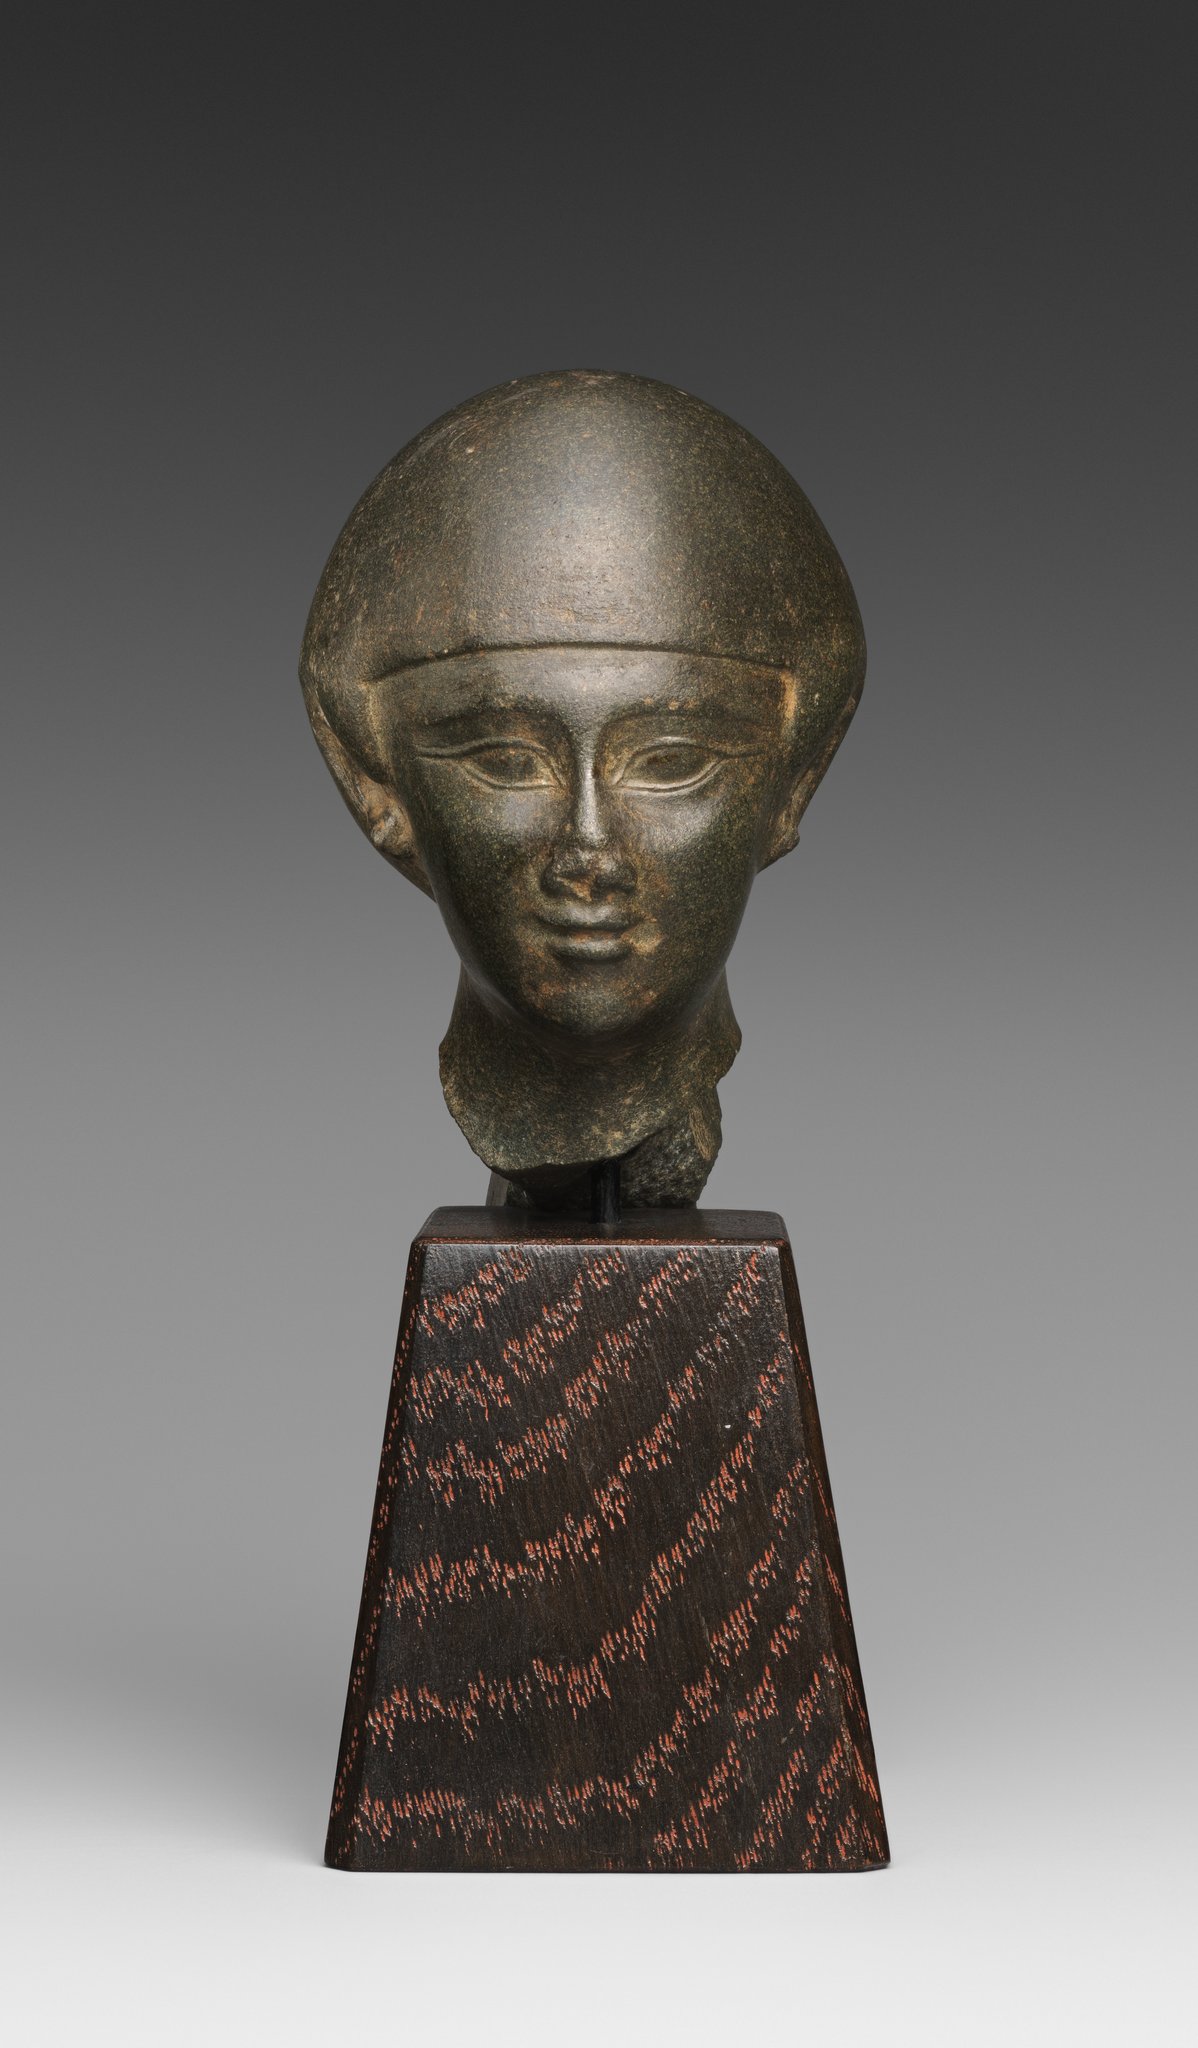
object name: head, mutnefret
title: Head of a young woman, Mutnefret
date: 400-301 BCE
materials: stone